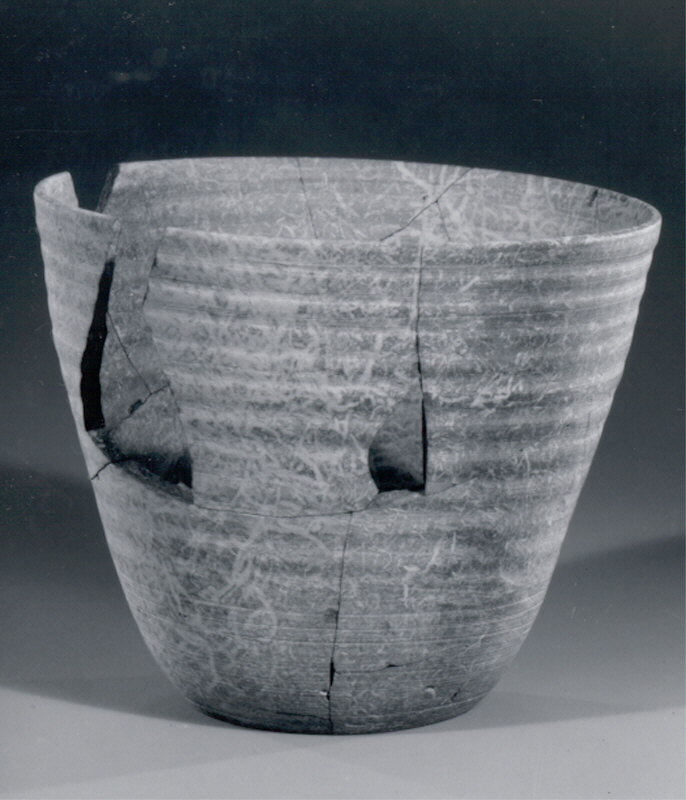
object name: beaker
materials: ceramic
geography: mesopotamia